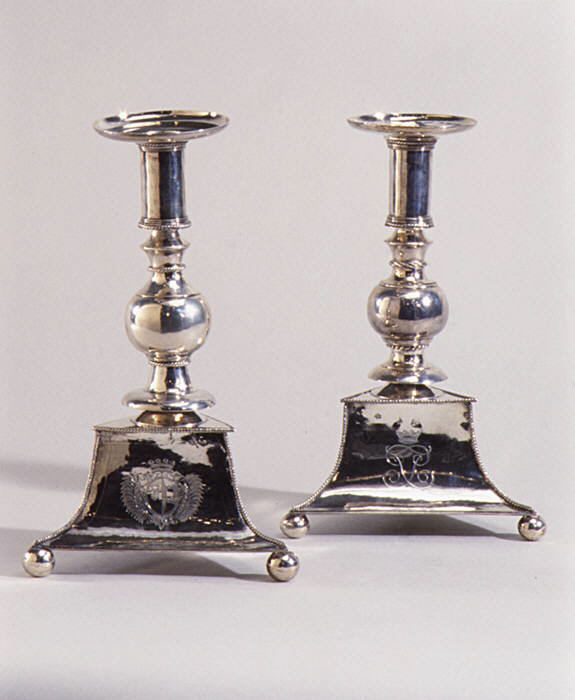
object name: candlestick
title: Candlestick (one of a set of six)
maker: j. c. (probably), london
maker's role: maker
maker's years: 1675-1676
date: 1675-1676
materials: silver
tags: coat of arms,insignia